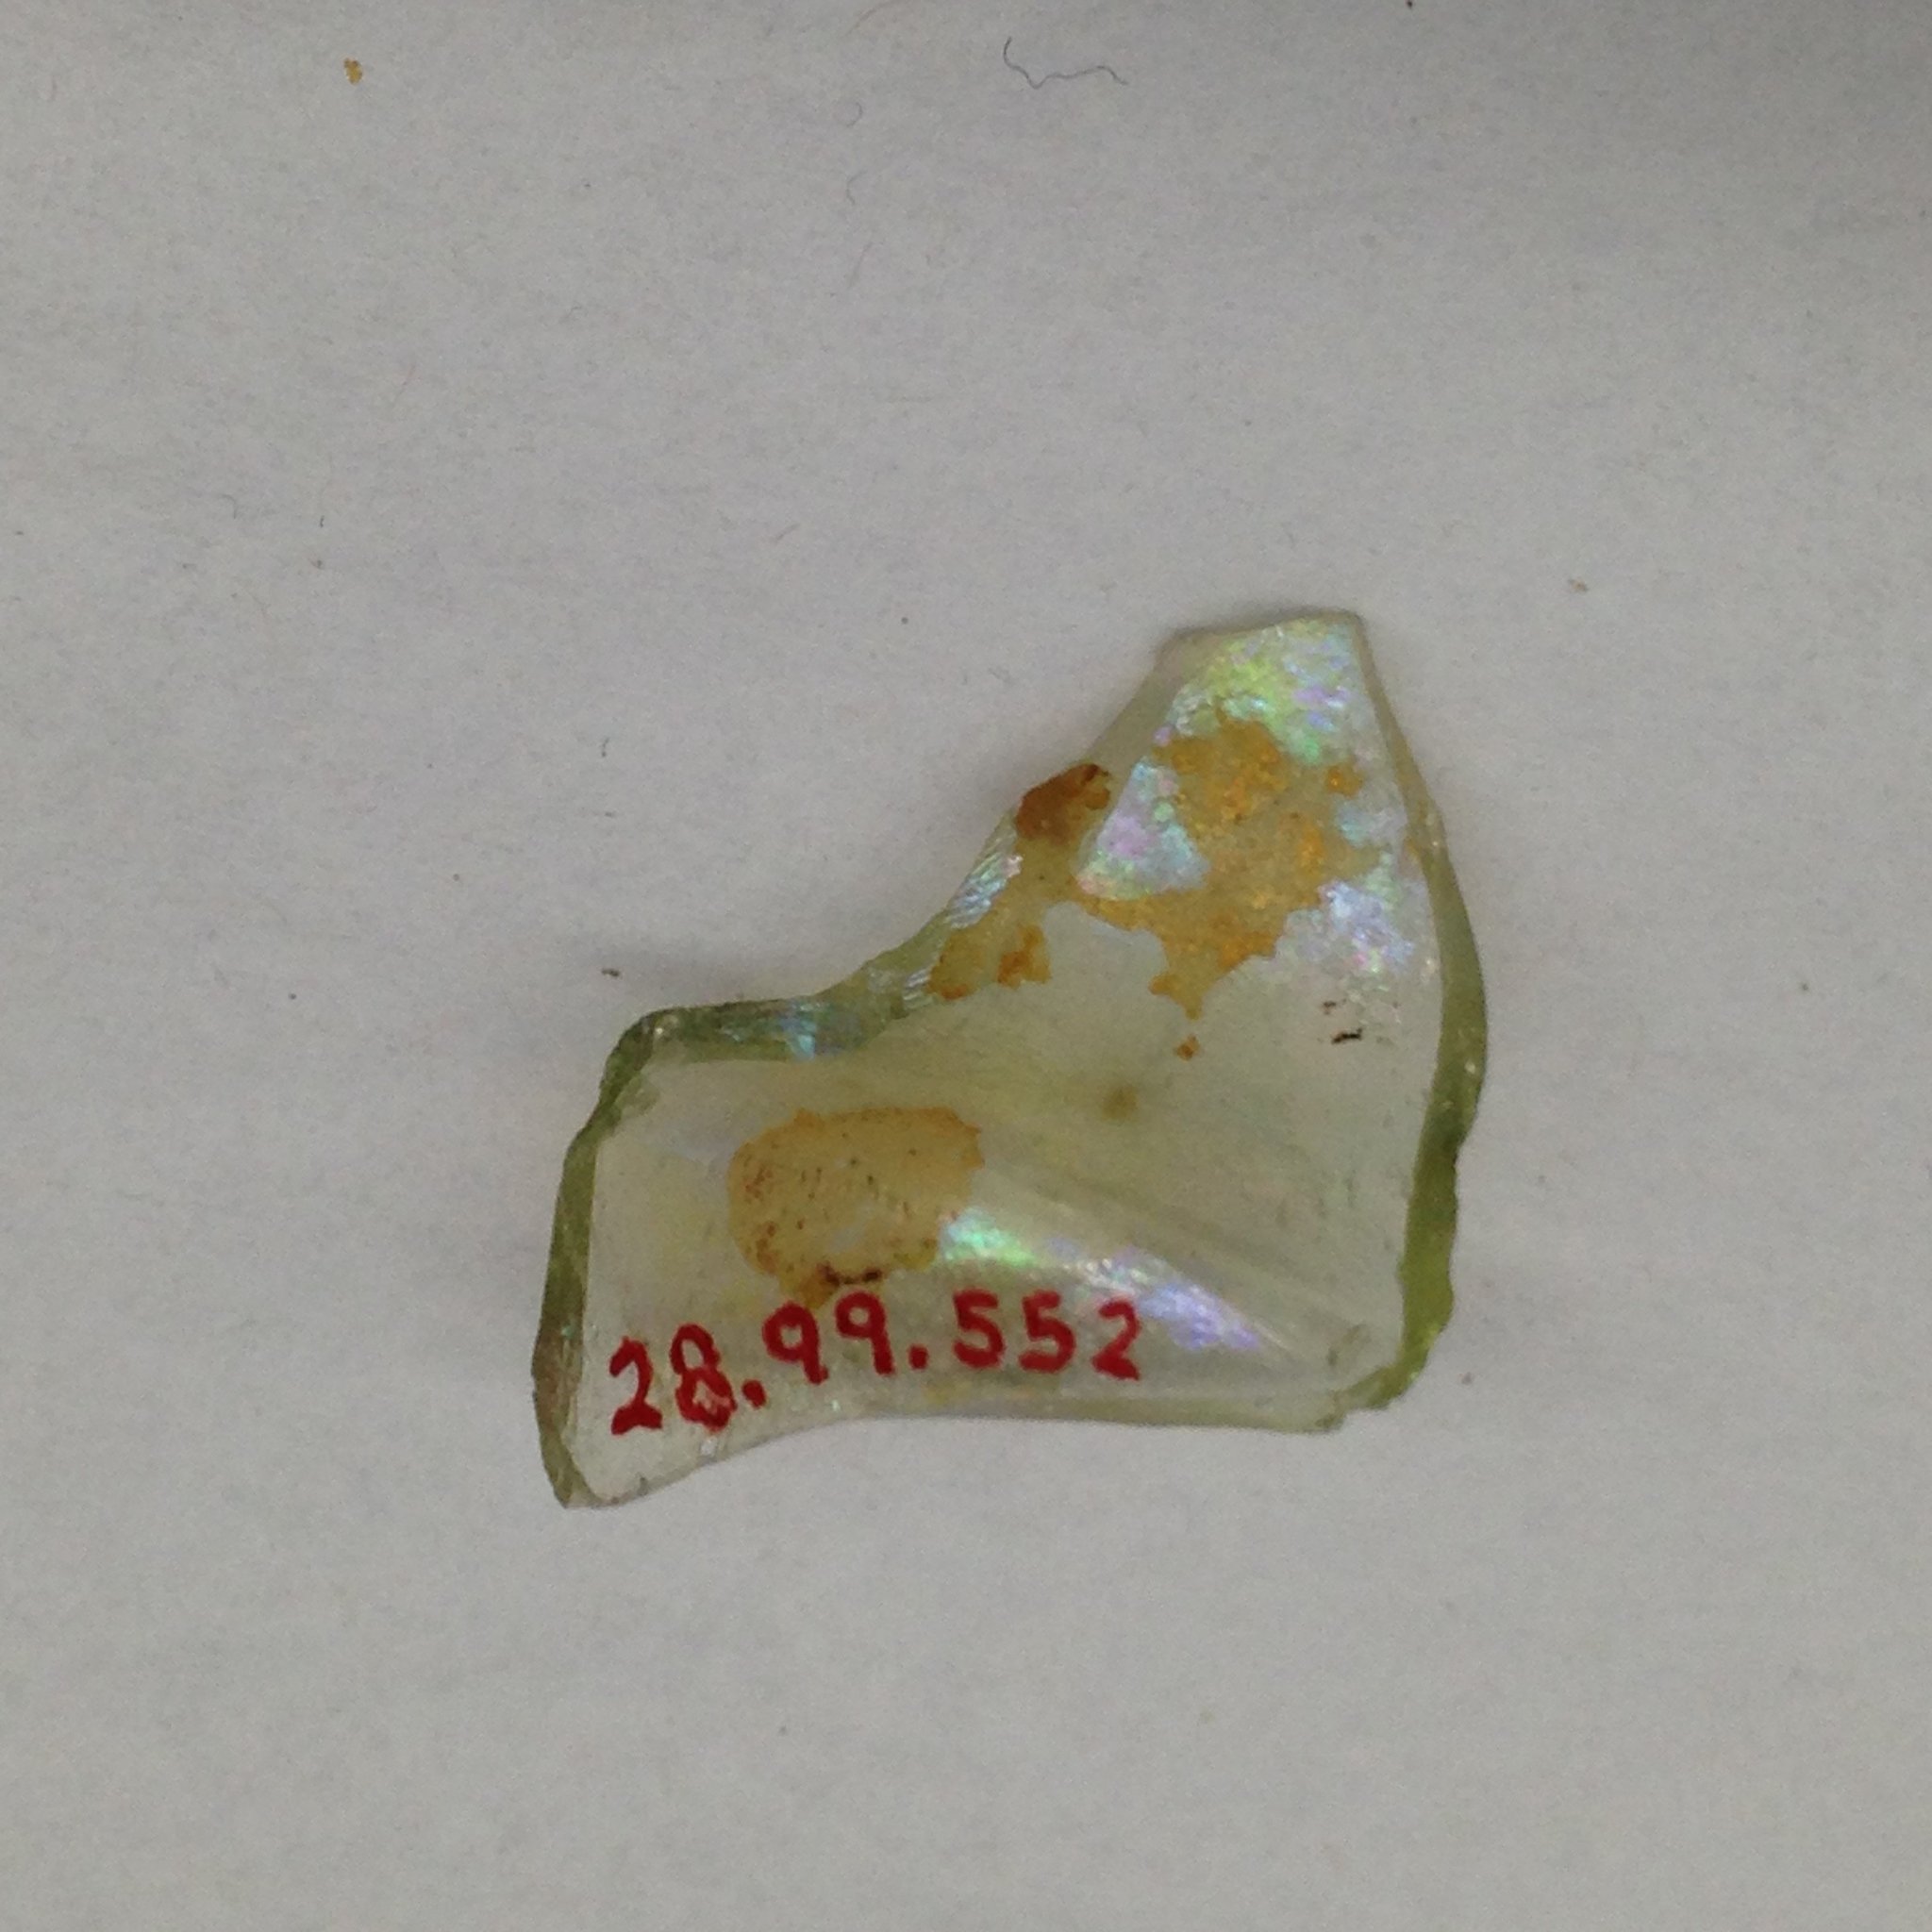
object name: fragment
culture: european or middle eastern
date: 1150-1250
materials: ceramic, glass